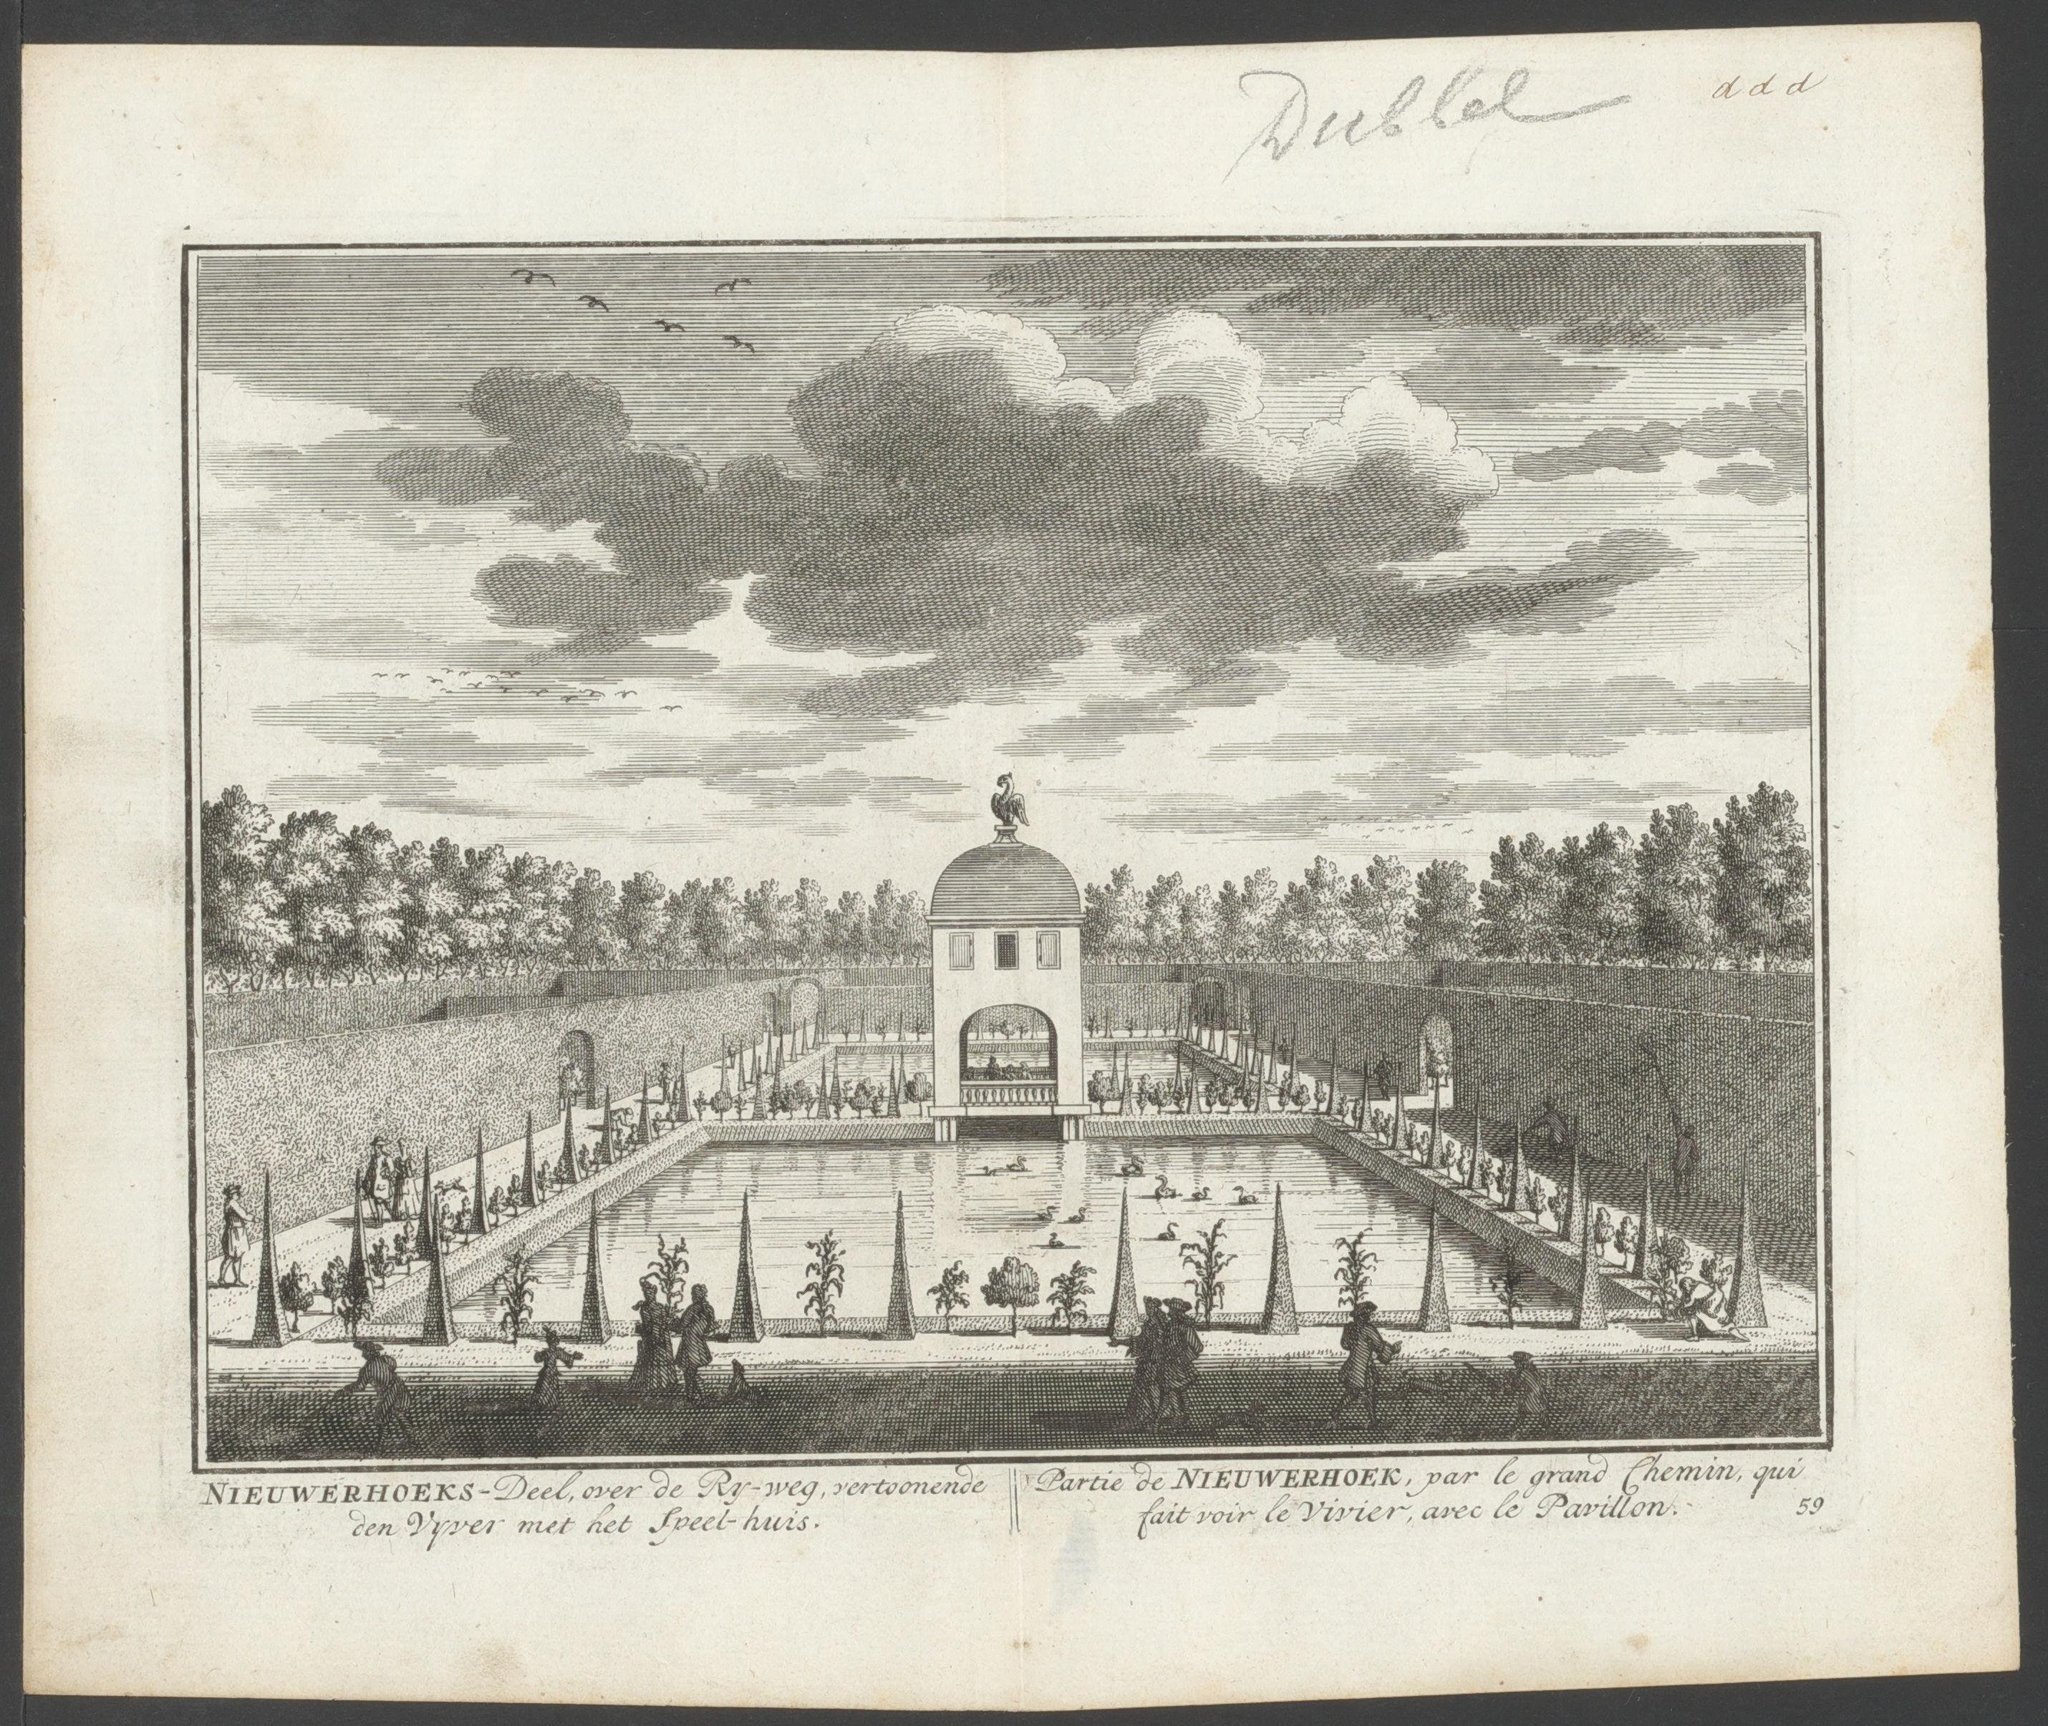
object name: print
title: Gezicht op de tuin met vijver en speelhuis van de buitenplaats Nieuwerhoek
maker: daniël stopendaal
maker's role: print maker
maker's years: 1672-1726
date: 1790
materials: paper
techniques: engraving, etching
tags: french or architectonic garden; formal garden, garden pond, river (+ landscape with figures, staffage), vecht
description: Prent voor het eerst gebruikt in: Leth, Andries de. De zegepraalende Vecht, vertoonende verscheidene gesichten van lustplaatsen, heeren huysen en dorpen, beginnende van Uitrecht en met Muyden besluytende (...). Amsterdam: Weduwe Nicolaus Visscher, 1719. Prent mogelijk uit: Brouërius van Nidek, Matthaeus. De Vechtstroom, van Utrecht tot Muiden (...). Amsterdam: H. Gartman, W. Vermandel en J.W. Smit, 1790.